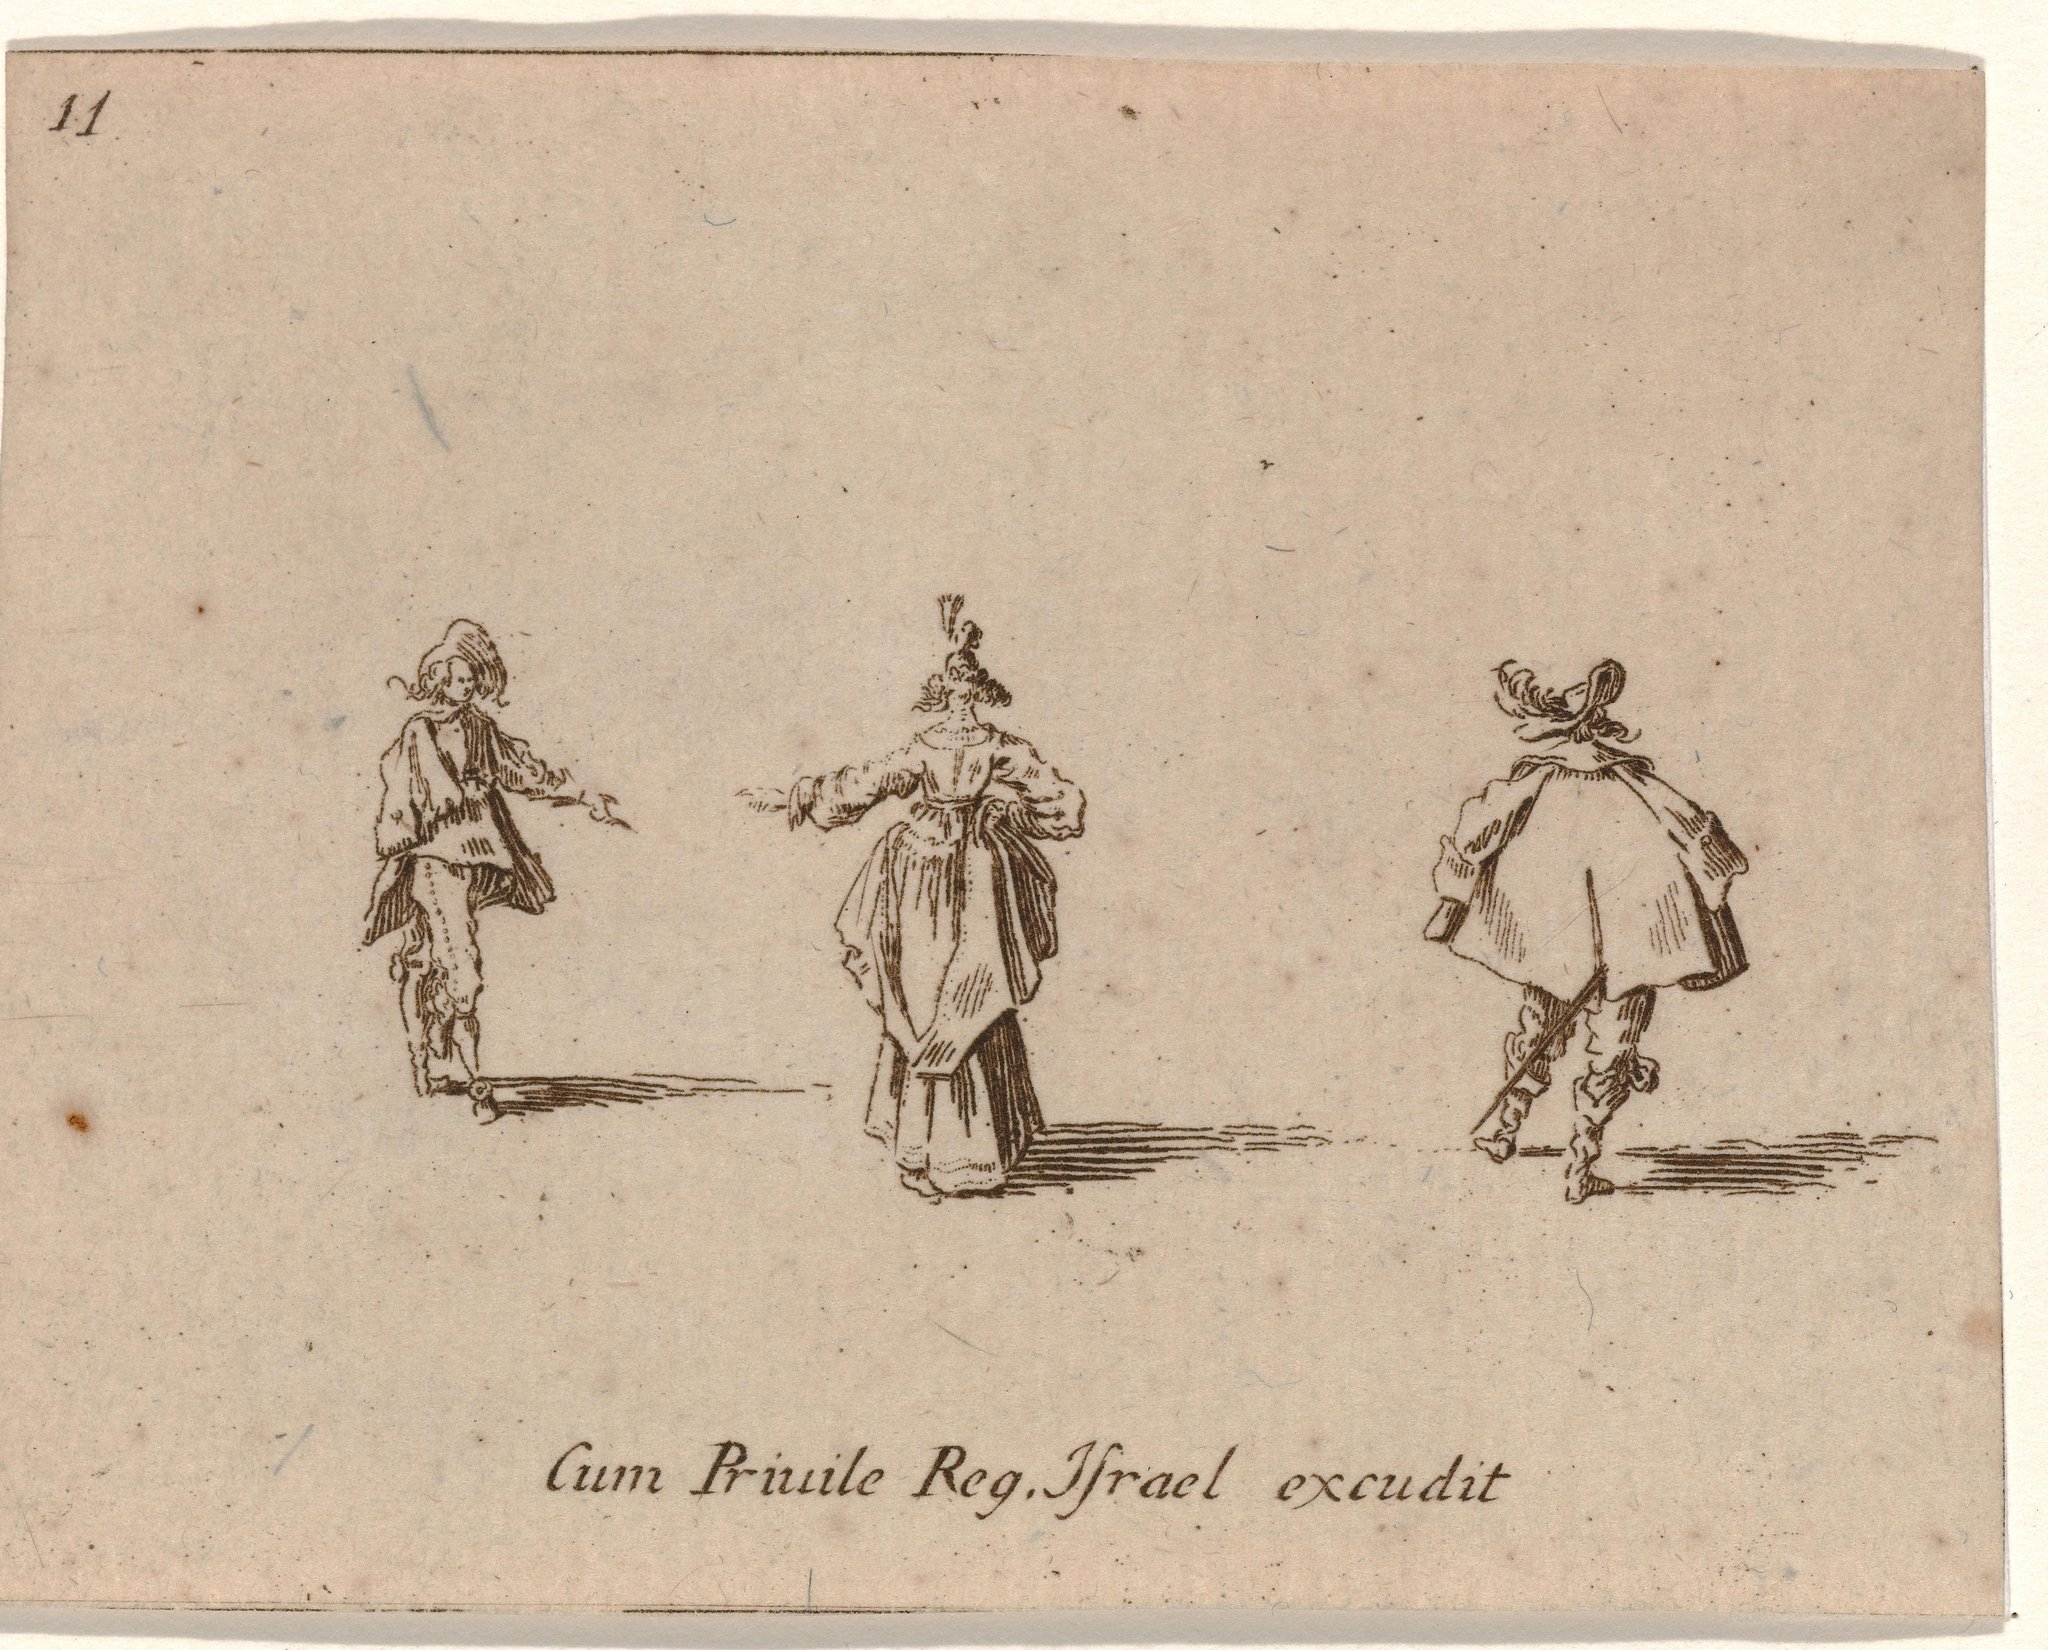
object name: print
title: Les Fantaisies de Noble Callot Mises en lumiere par Israel son amy, a Monseigneur Jean Louis de Bauffremont Comte de Randan Baron du Luguet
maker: israël henriet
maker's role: printer, publisher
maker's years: 1590-1661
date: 1635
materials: paper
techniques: etching